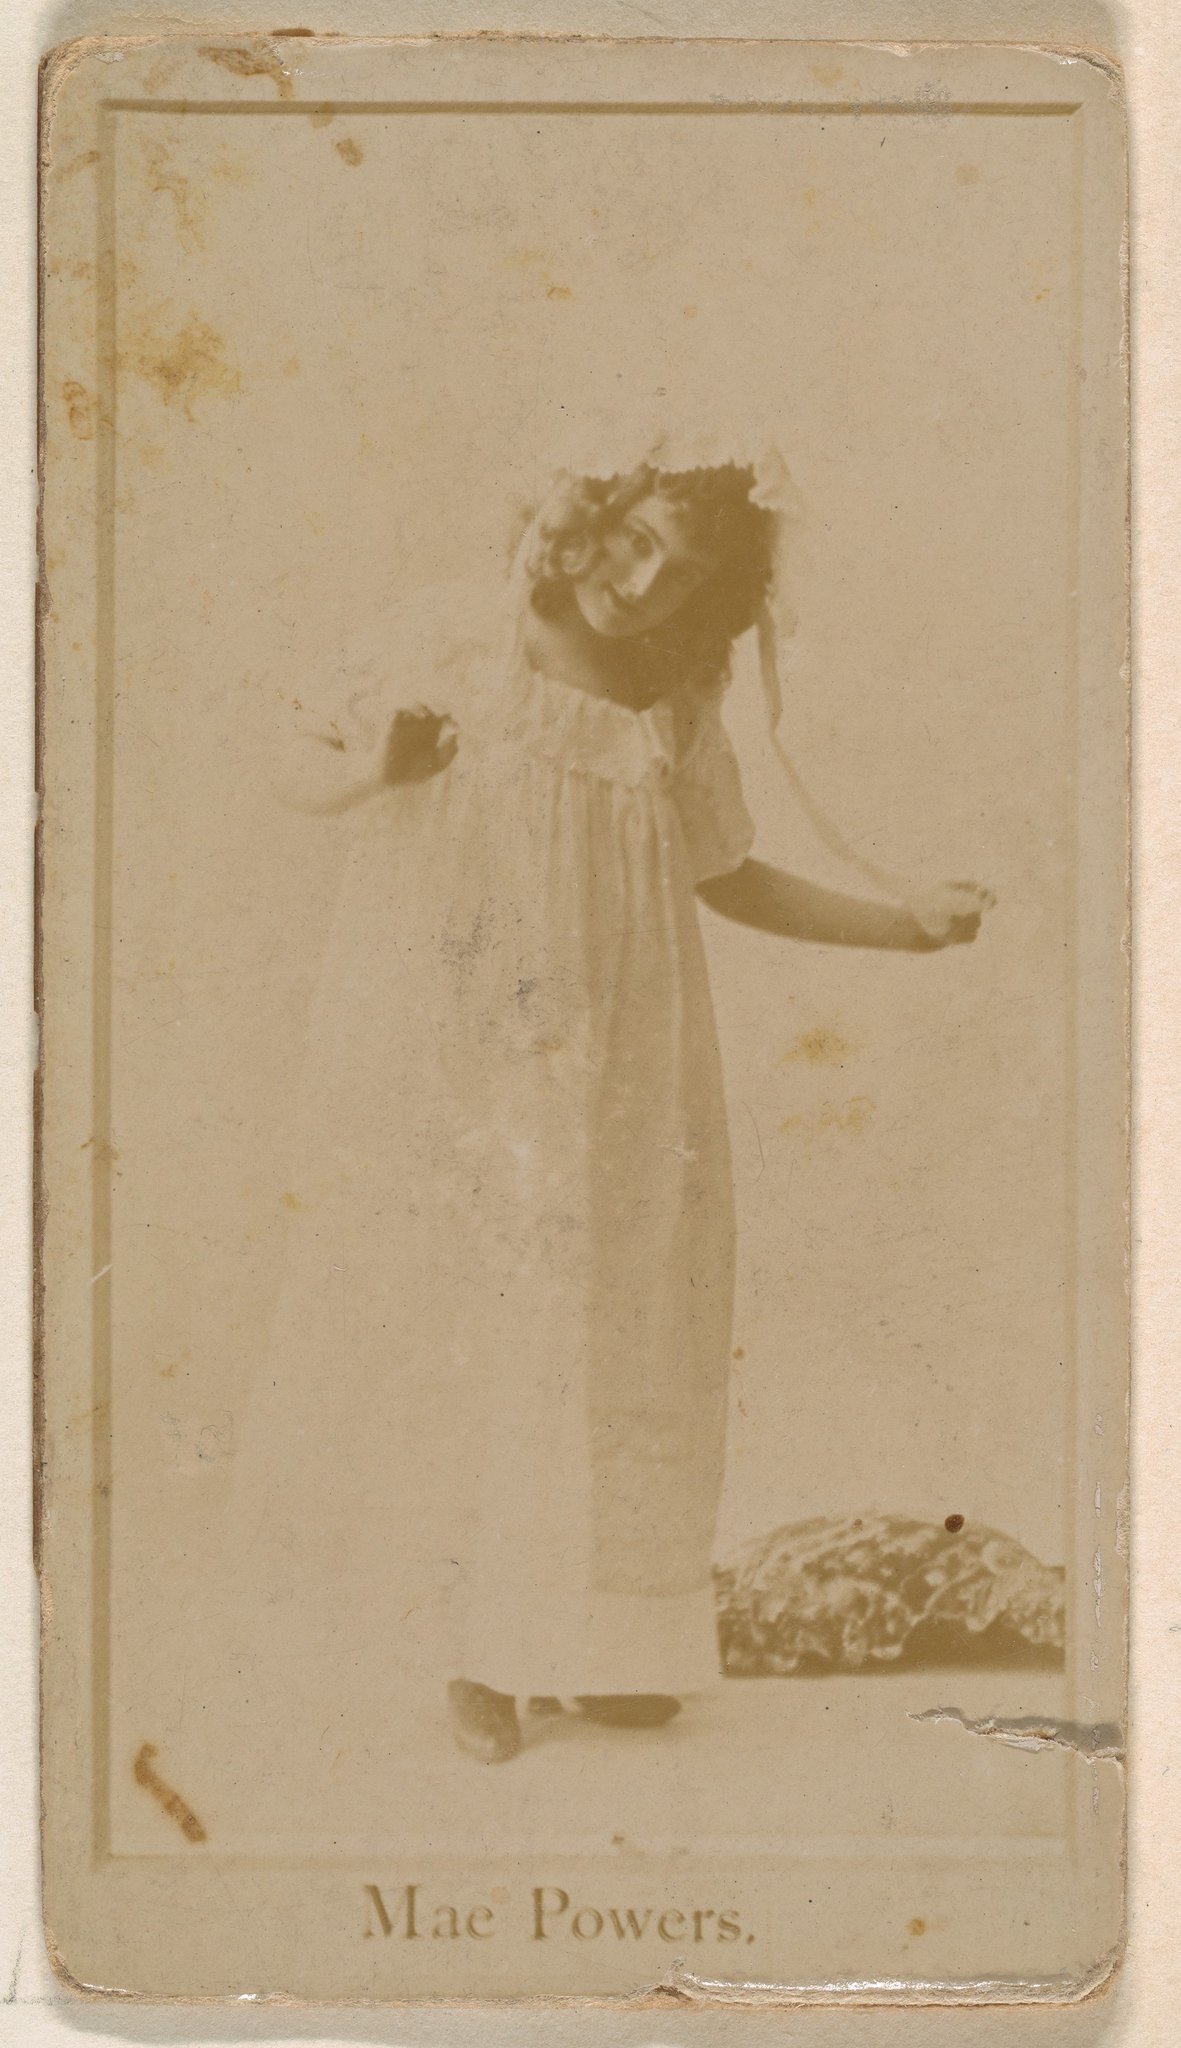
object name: photograph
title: Mae Powers, from the Actresses series (N245) issued by Kinney Brothers to promote Sweet Caporal Cigarettes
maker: kinney brothers tobacco company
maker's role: publisher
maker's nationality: american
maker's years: 1869-2011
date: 1890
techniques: albumen silver print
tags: portraits,women,actresses